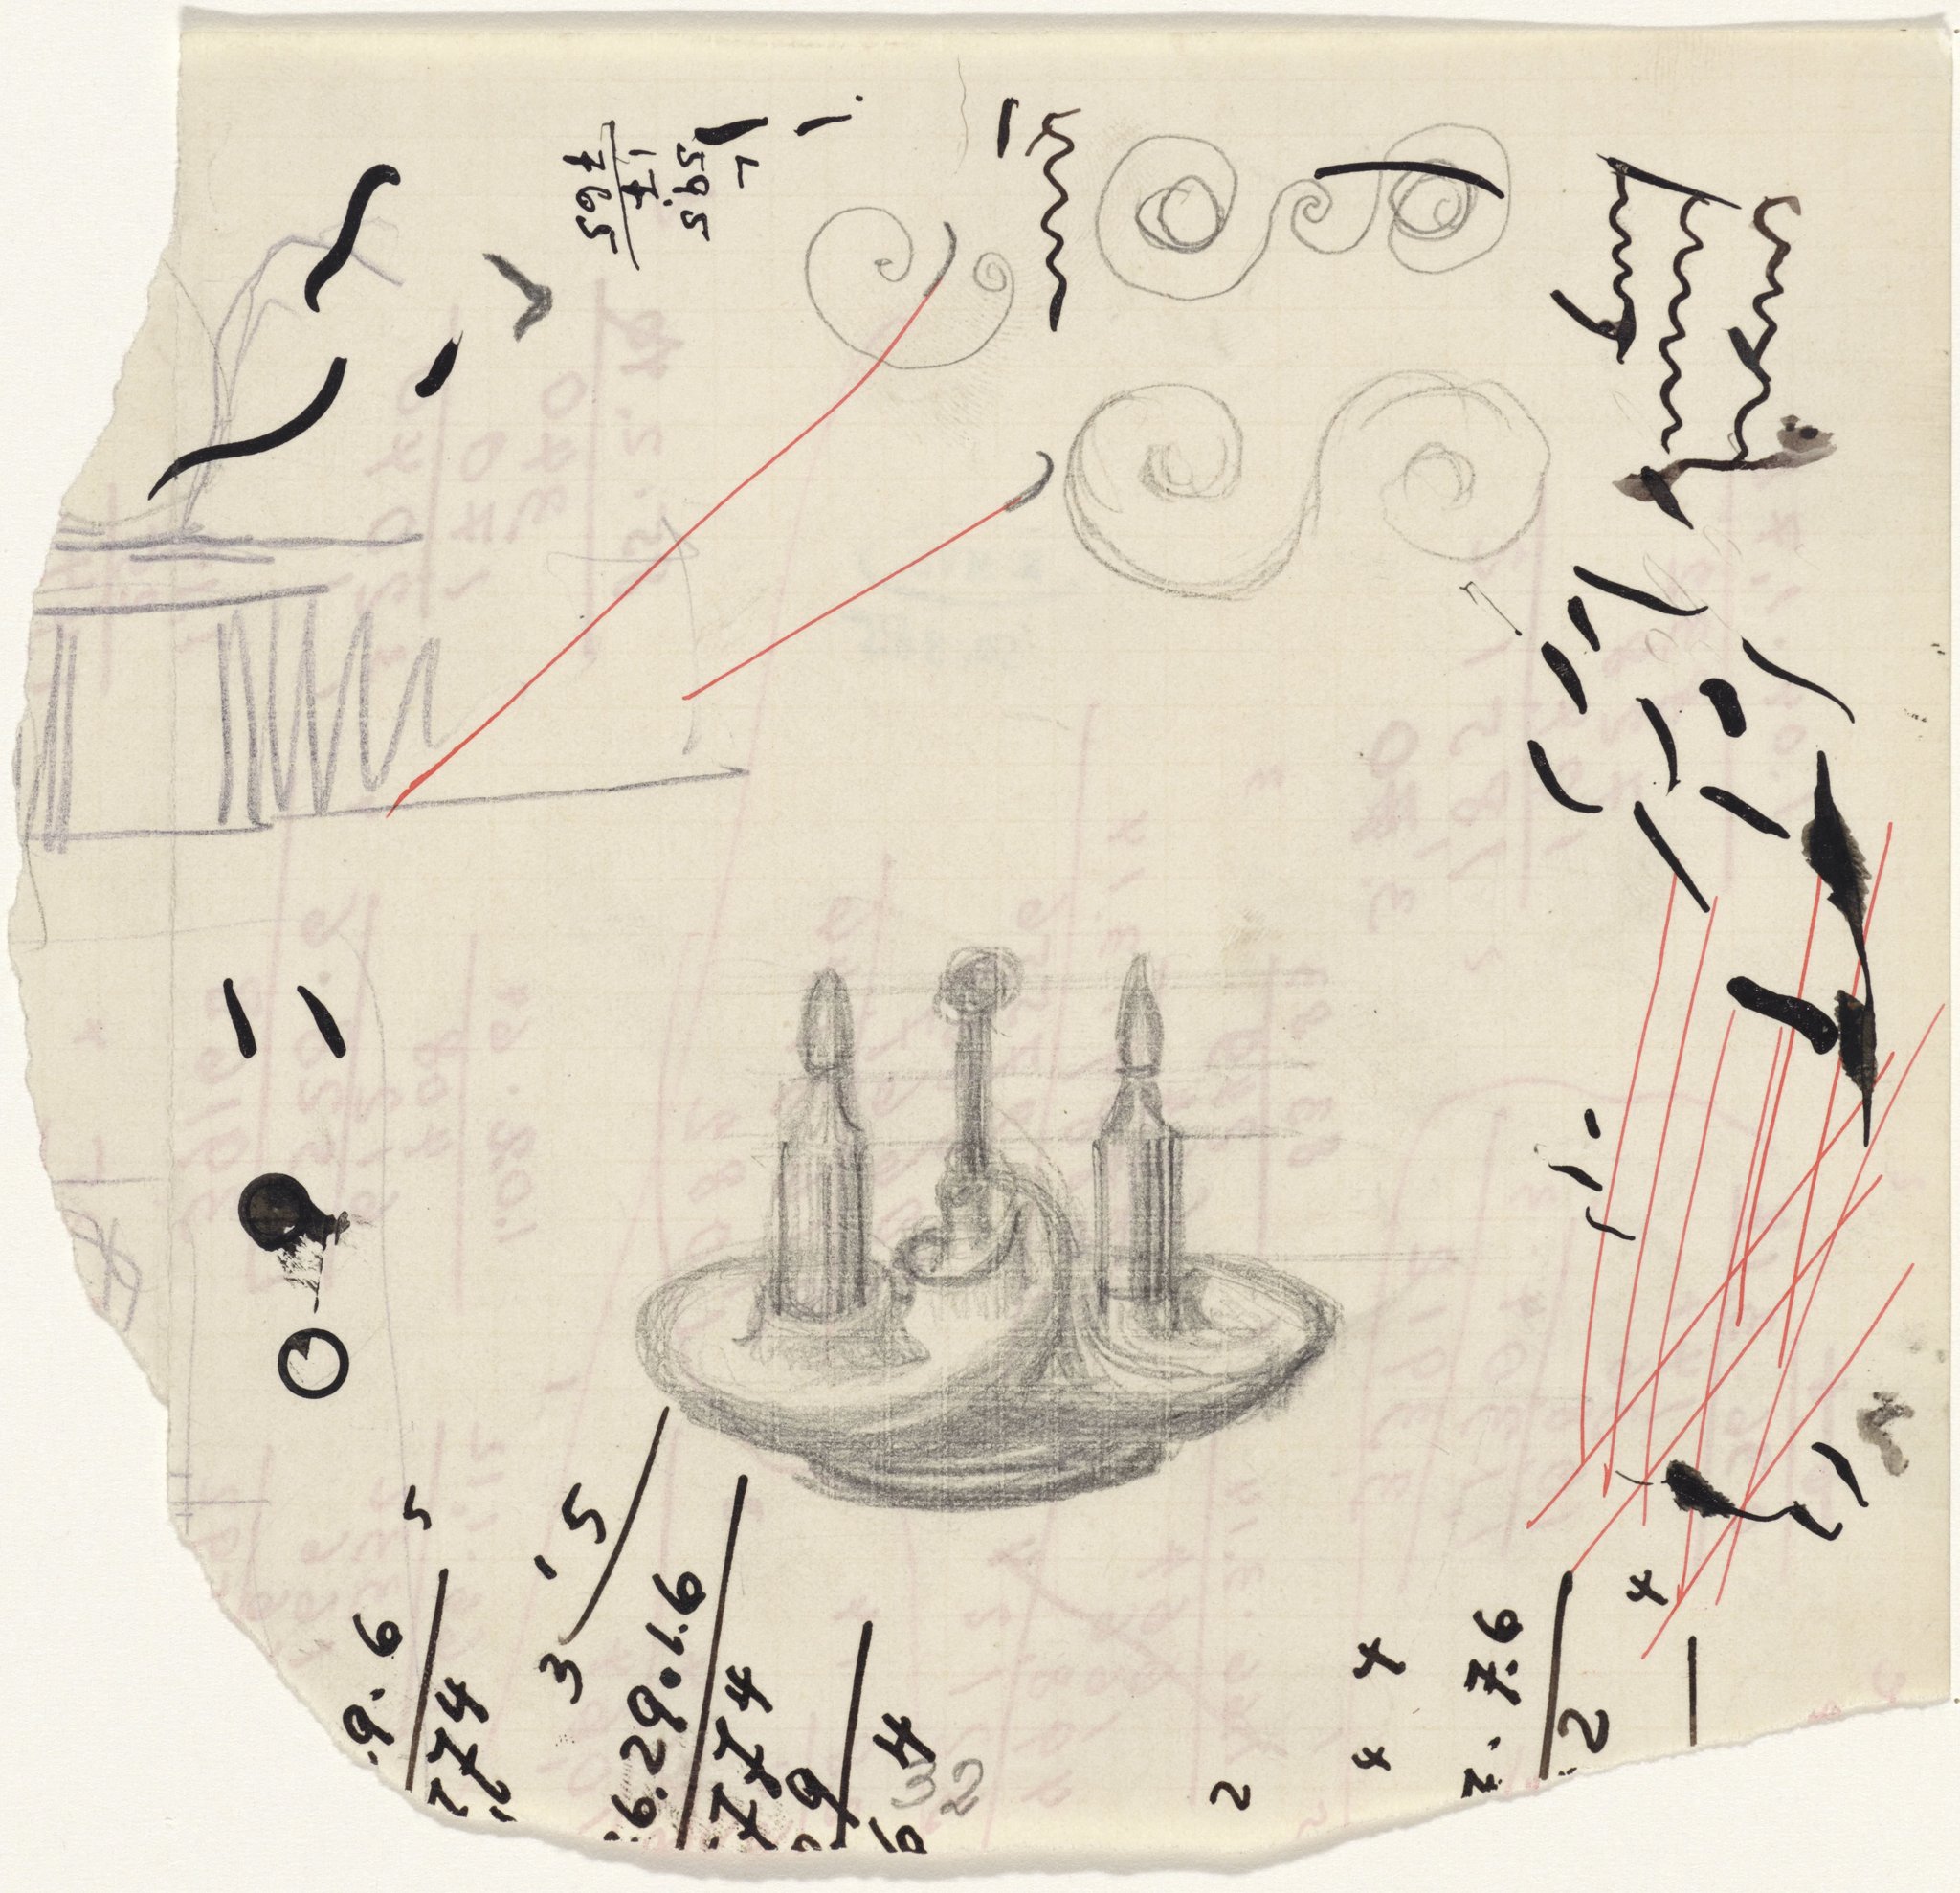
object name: design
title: Ontwerp voor een peper-en-zoutstel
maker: mathieu lauweriks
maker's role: designer, draughtsman, print maker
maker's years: 1864-1932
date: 1874-1932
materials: pencil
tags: spice-box, salt-cellar, salt-shaker